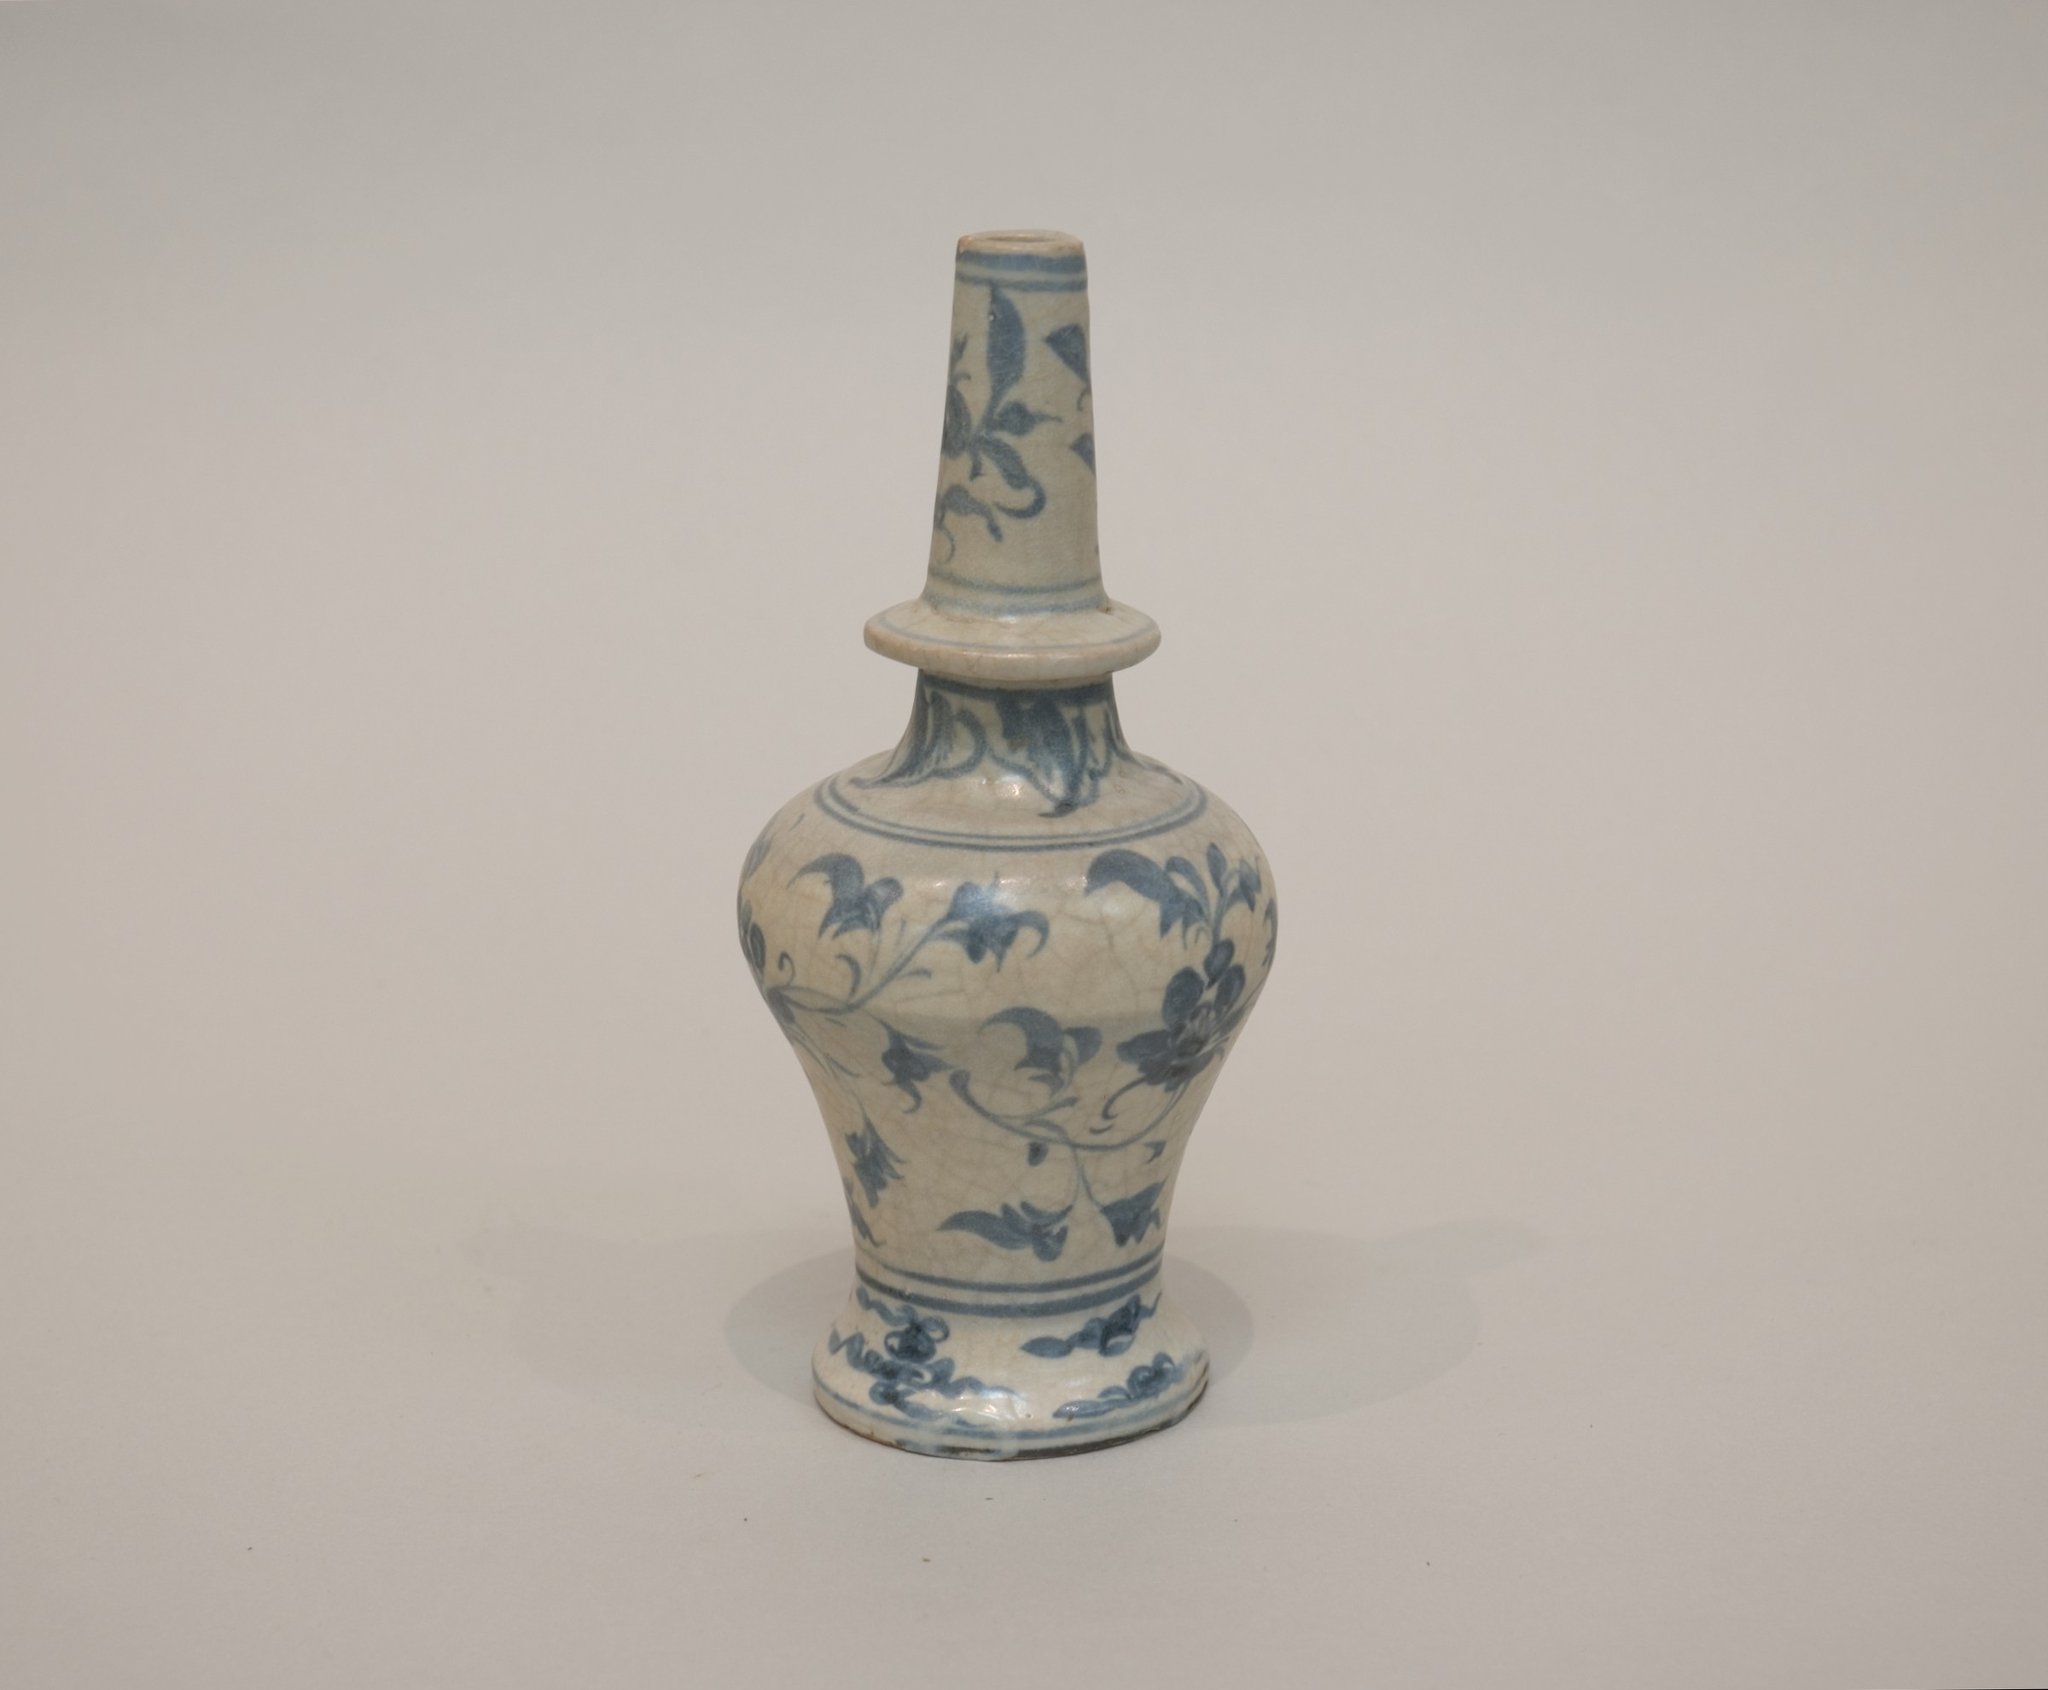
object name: sprinkler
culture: chinese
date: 1434-1466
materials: cobalt, porcelain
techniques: painting, underglaze